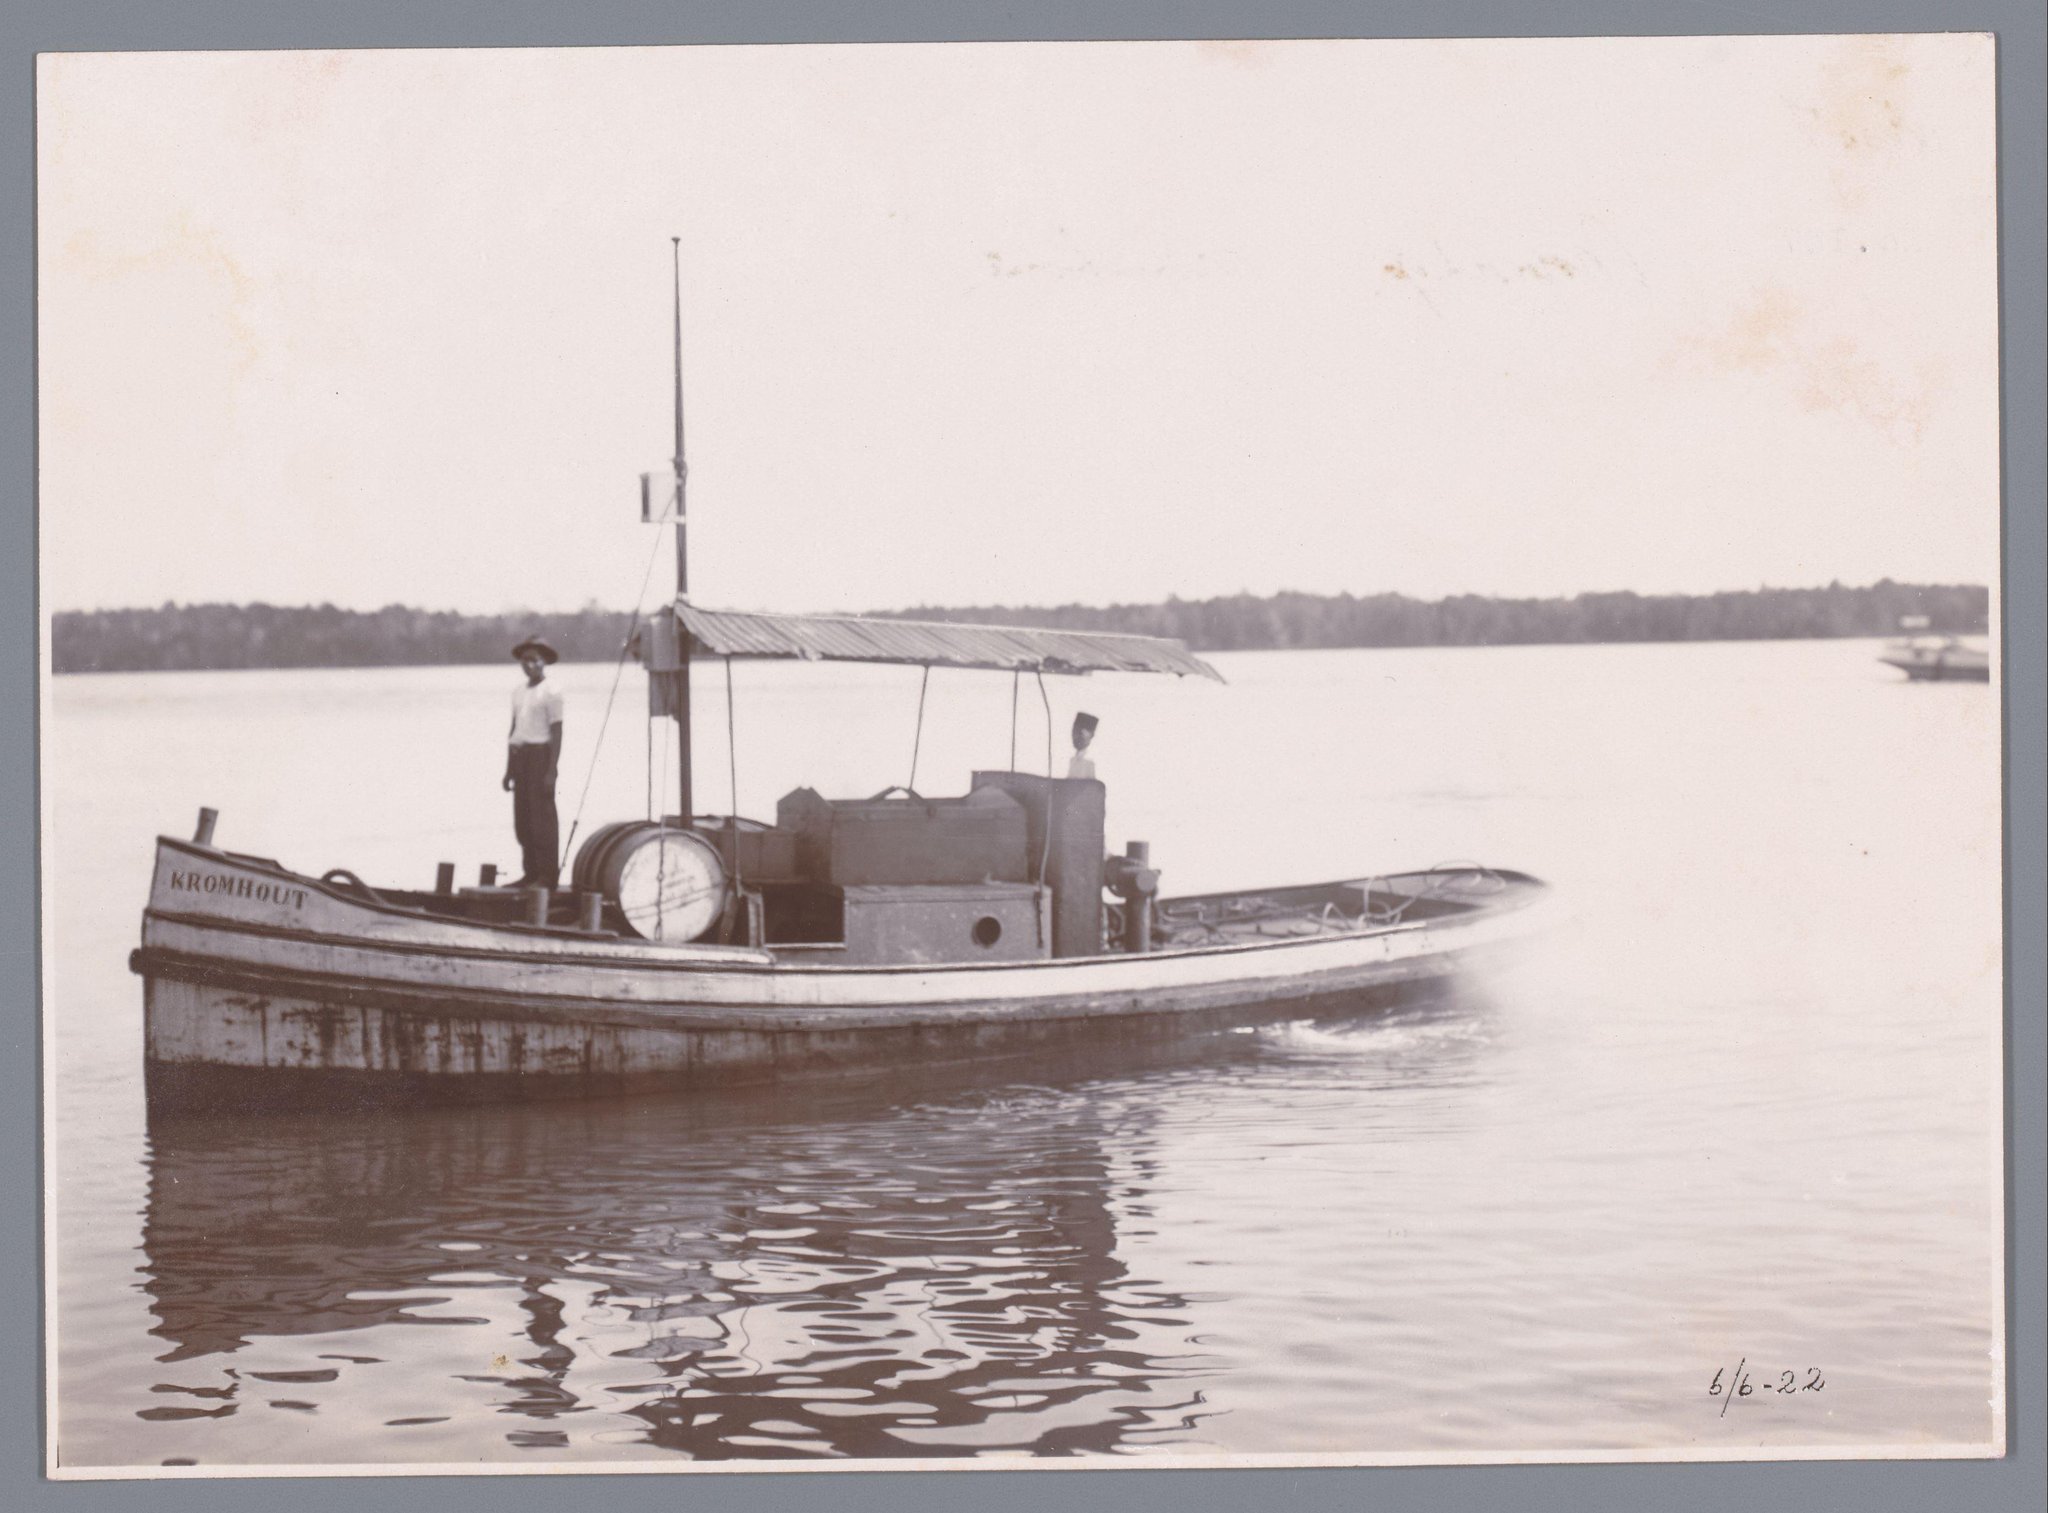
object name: photograph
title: Oceaanhaven Belawan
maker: Anonymous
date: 1922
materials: photographic support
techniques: gelatin silver print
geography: belawan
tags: harbour, building-site, steamship, motorship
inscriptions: inscription: ‘No 167 Motorschip "Kromhout"’, date: ‘6/6-22’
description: Het motorschip "Kromhout". Genummerd: 167. Onderdeel van de groep van losse foto's over de aanleg van de haven Belawan aan de kust voor Medan, Sumatra 1921-1922.